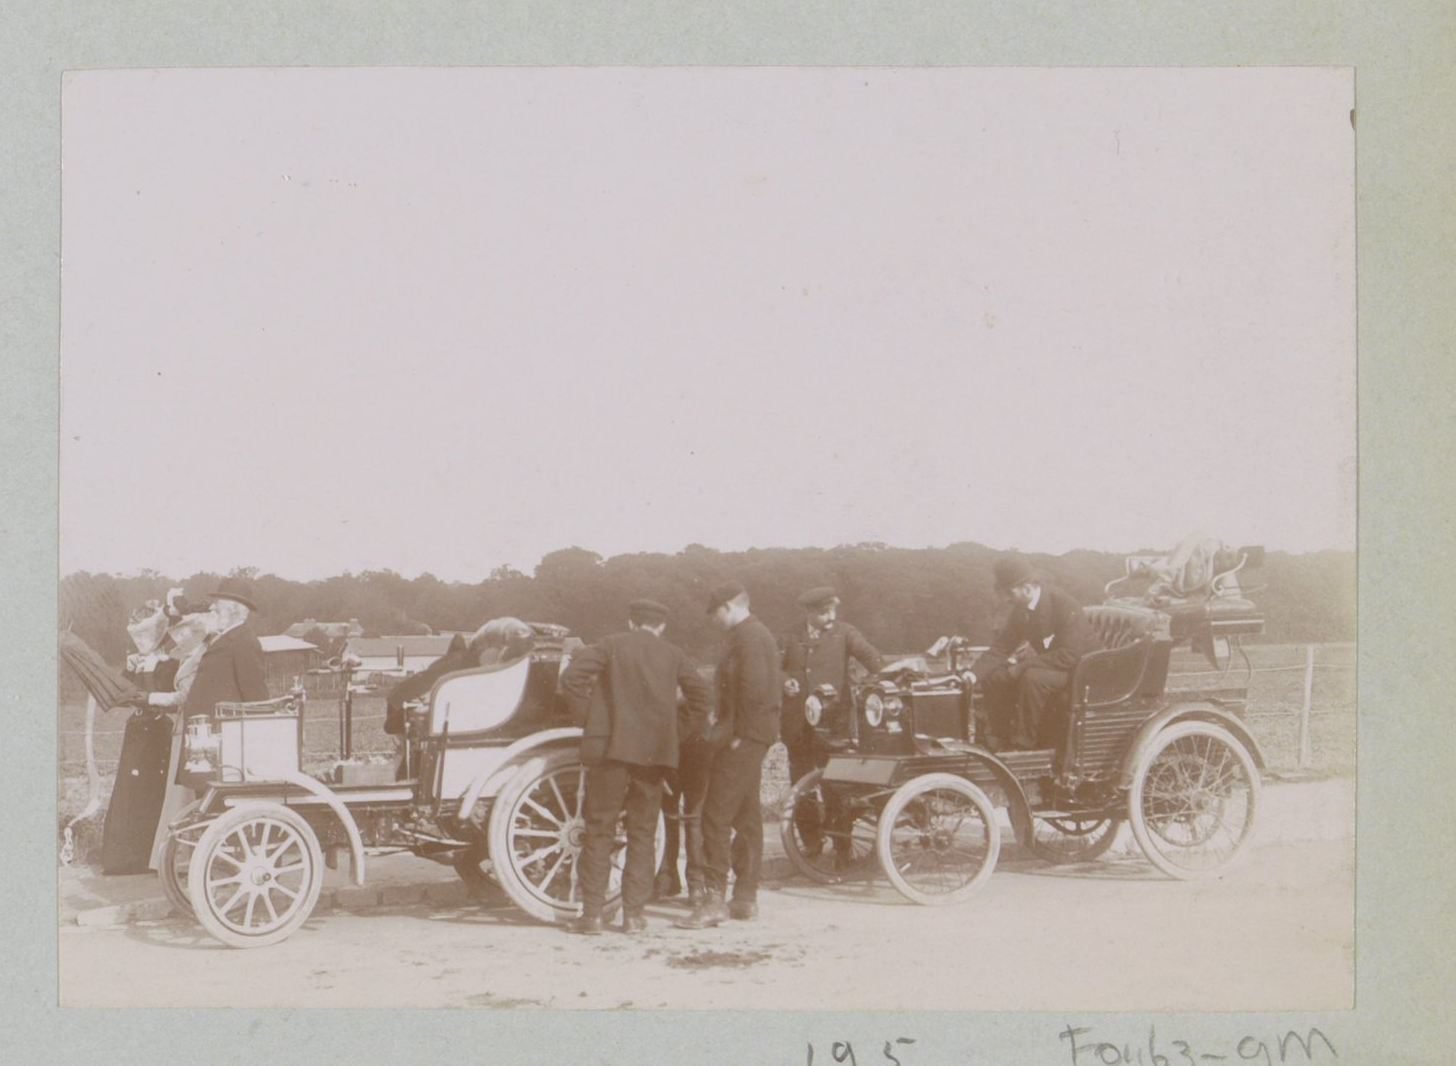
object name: photograph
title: Gezelschap bij twee automobielen in Frankrijk, waarschijnlijk tijdens een race voor Mors-automobielen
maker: delizy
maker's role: manufacturer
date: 1810-1898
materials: paper, photographic support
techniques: gelatin silver print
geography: france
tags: maintenance, repair, storage ~ motor vehicles, motorcar racing, automobile, france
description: Onderdeel van Fotoalbum van een Franse amateurfotograaf met opnames van uitstapjes in Frankrijk, Spanje, België, Luxemburg en Nederland, de eerste automobielen en autoraces.